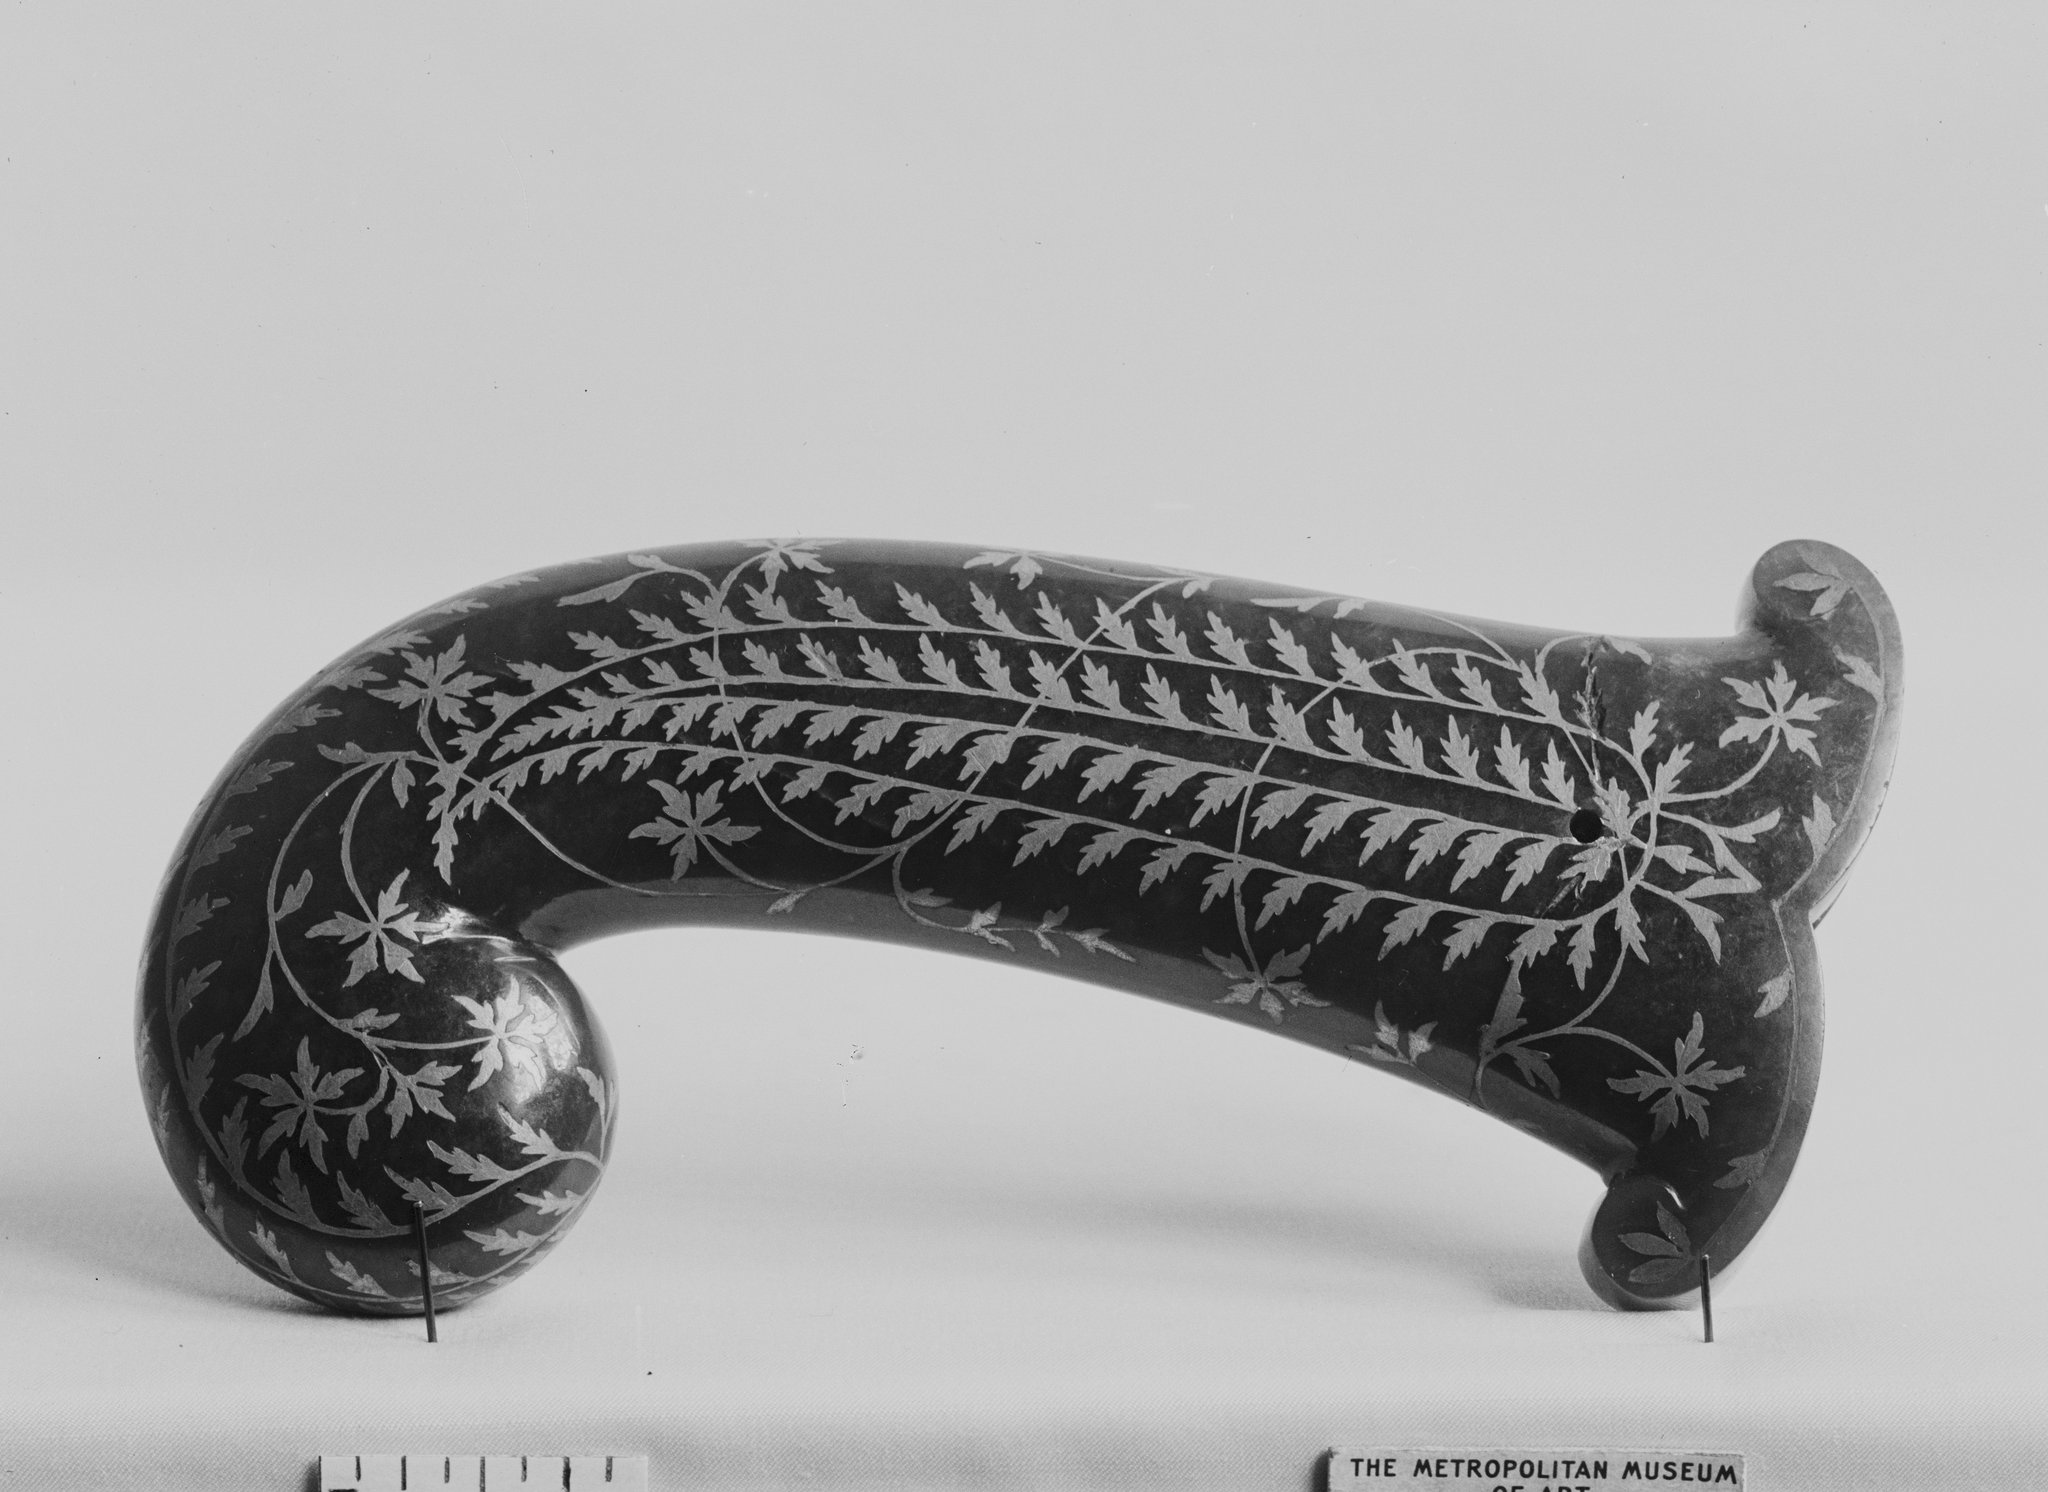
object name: dagger handle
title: Dagger-Handle Inlaid with Silver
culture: indian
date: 1801-1900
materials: jade